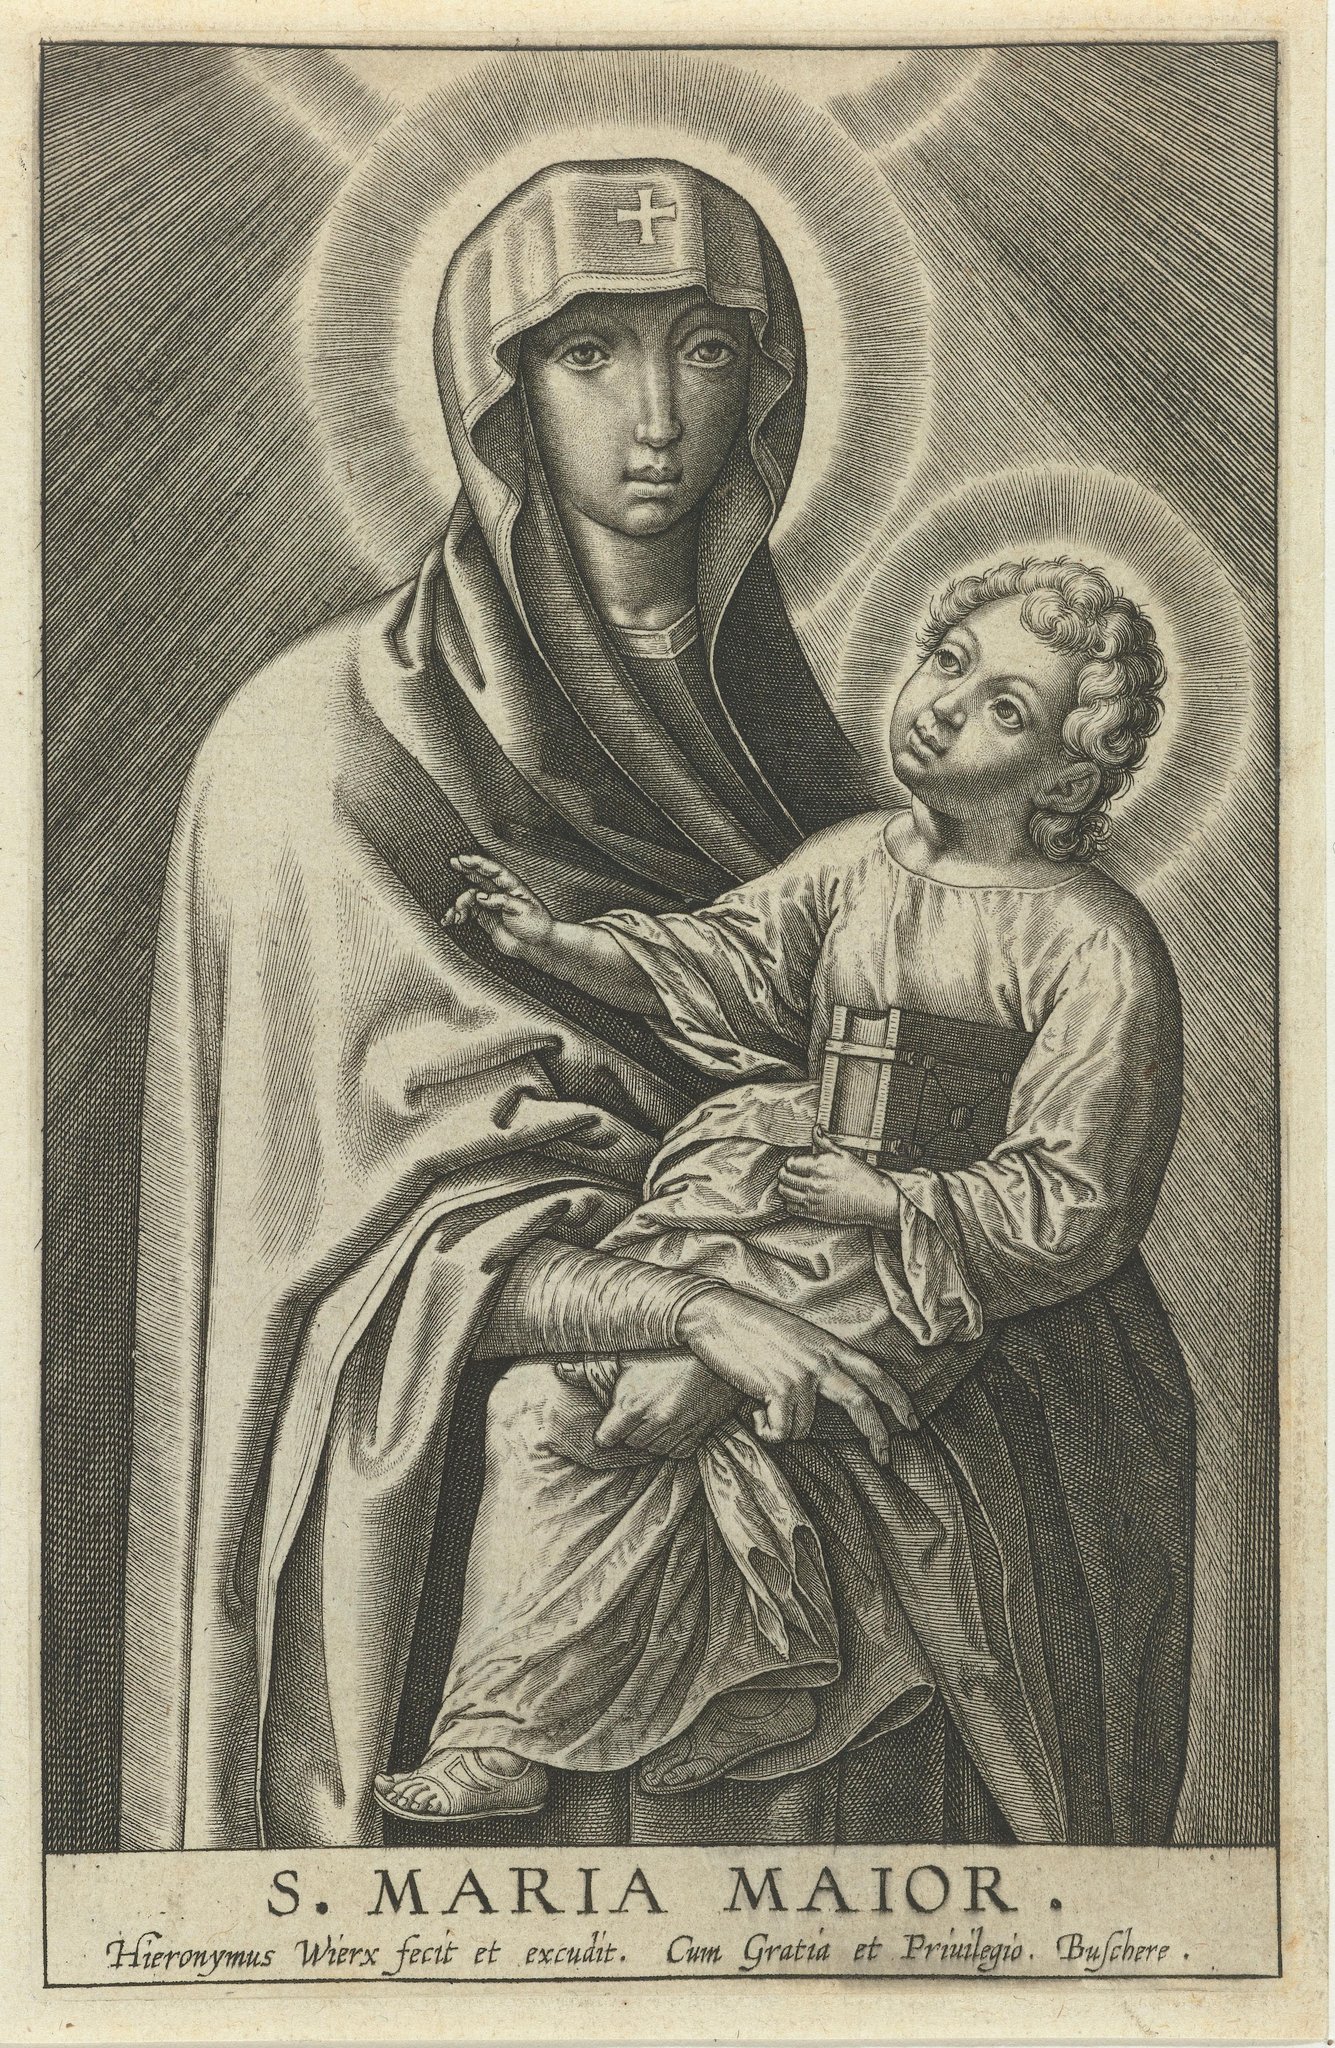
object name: print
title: Maria met het Christuskind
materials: paper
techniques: engraving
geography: antwerp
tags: mary standing (or half-length), the christ-child on her arm (christ-child to mary's left)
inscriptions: collector's mark: Lugt 2228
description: De gesluierde Maria draagt het Christuskind in haar armen. Het Kind houdt een boek onder de arm en maakt een zegenend gebaar.